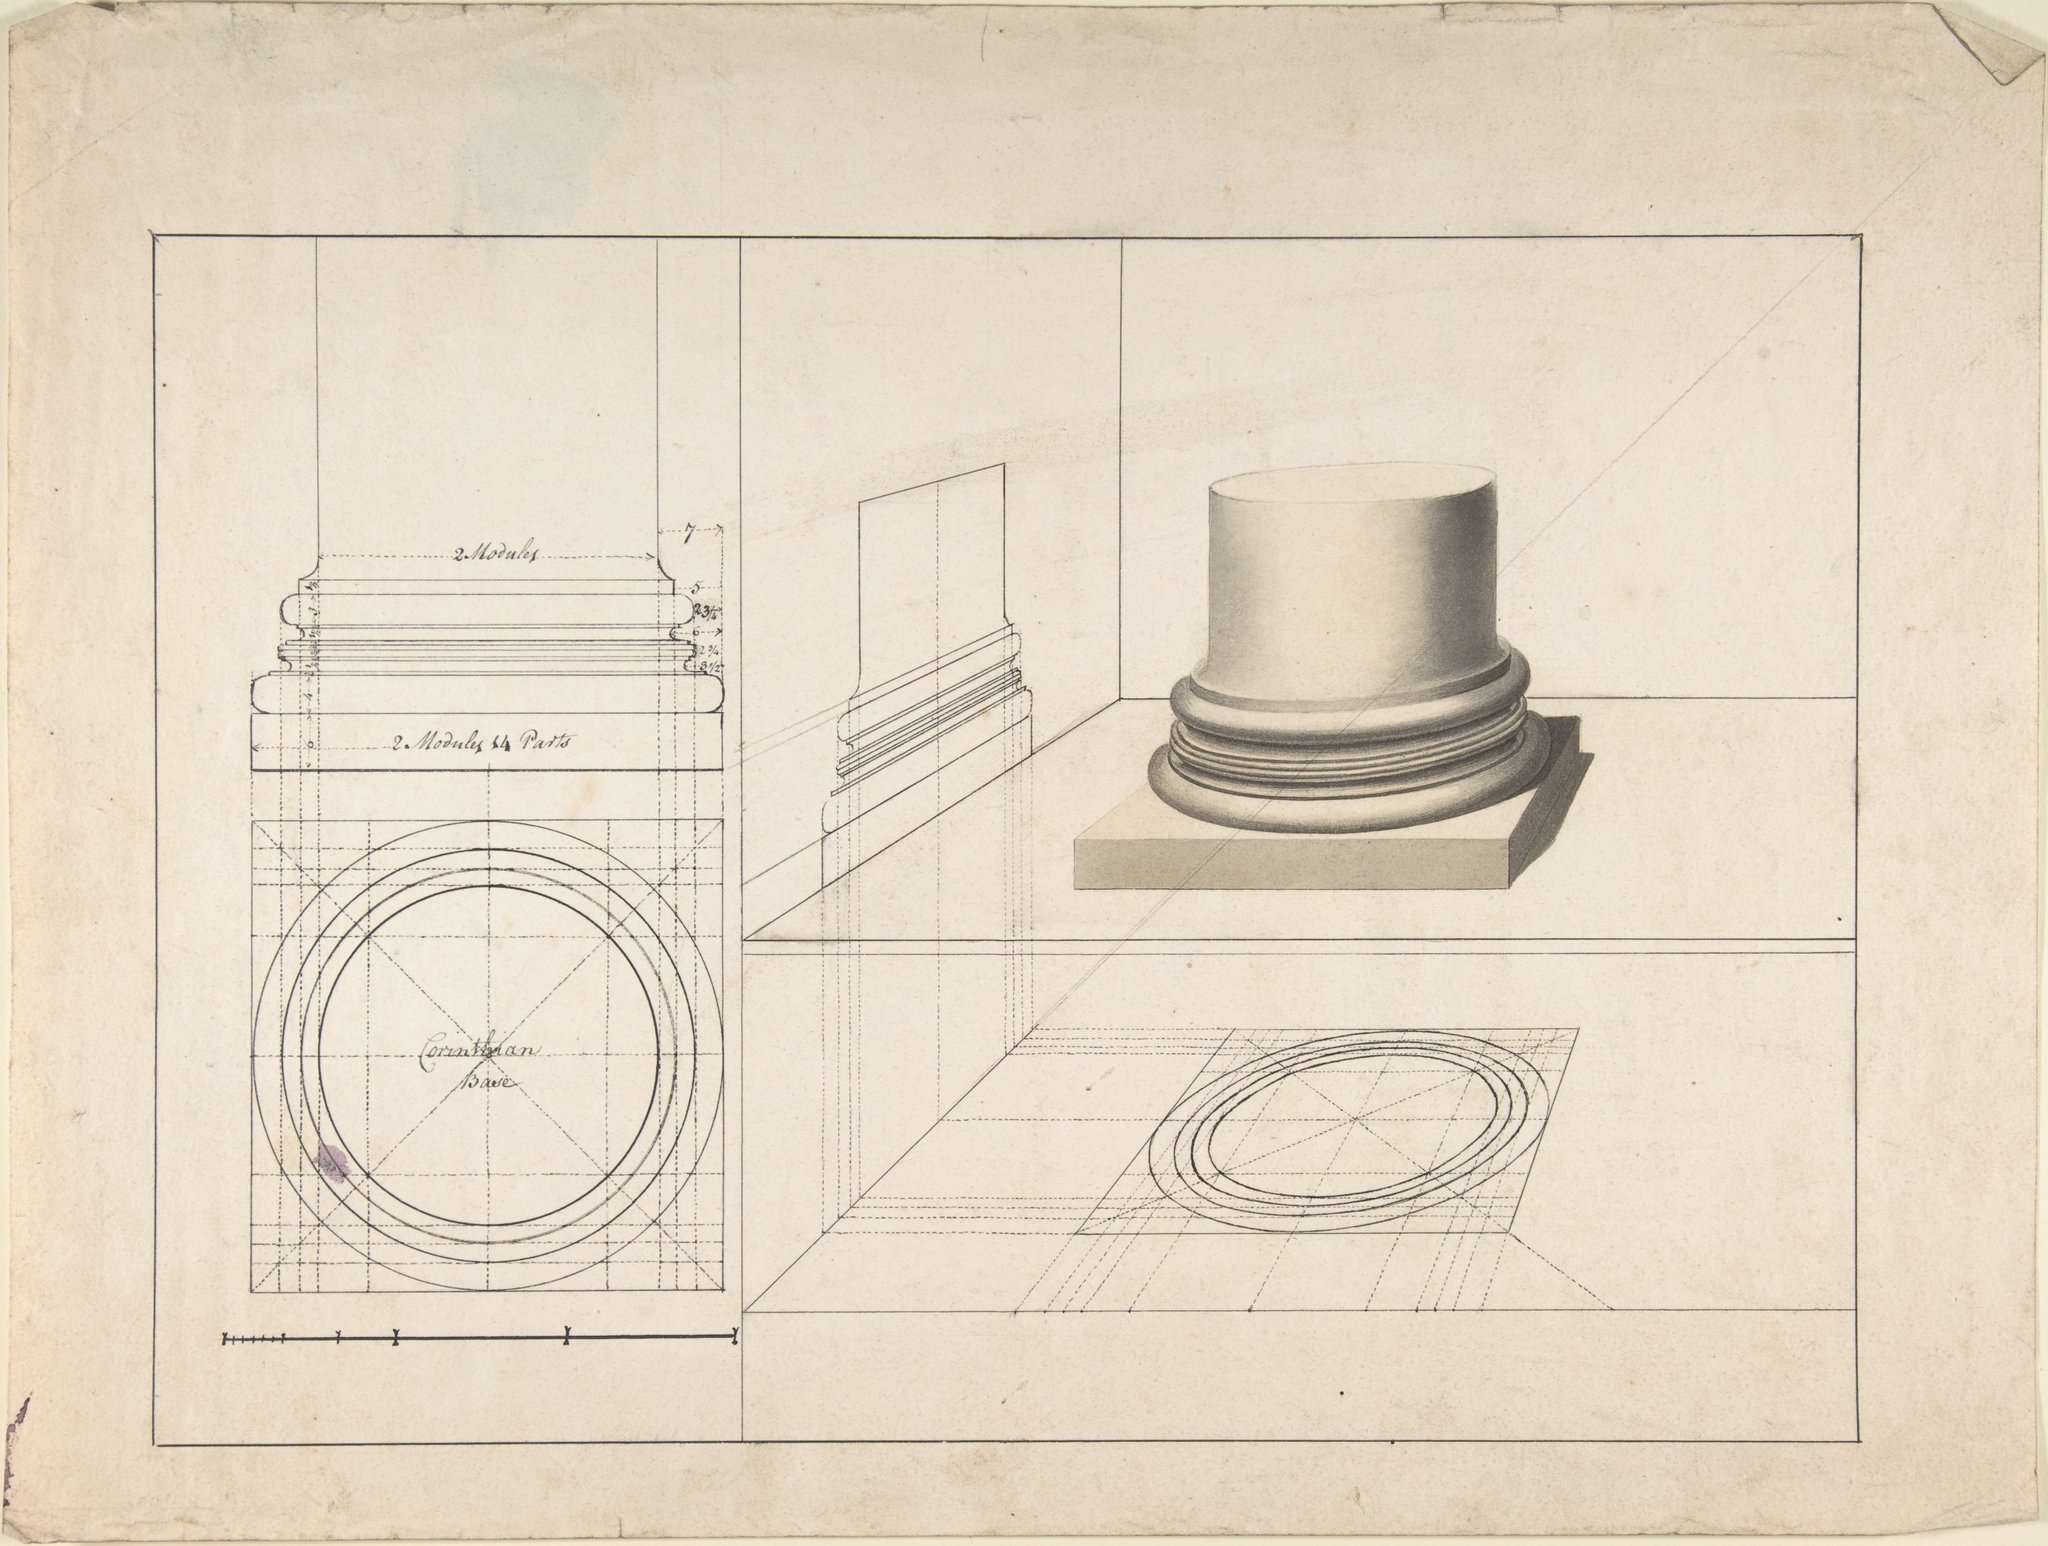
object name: drawing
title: Projections of Columns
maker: anonymous, british, 18th century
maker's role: artist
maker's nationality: british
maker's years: 1700-1800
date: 1701-1800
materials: ink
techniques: brush, pen, wash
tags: architecture